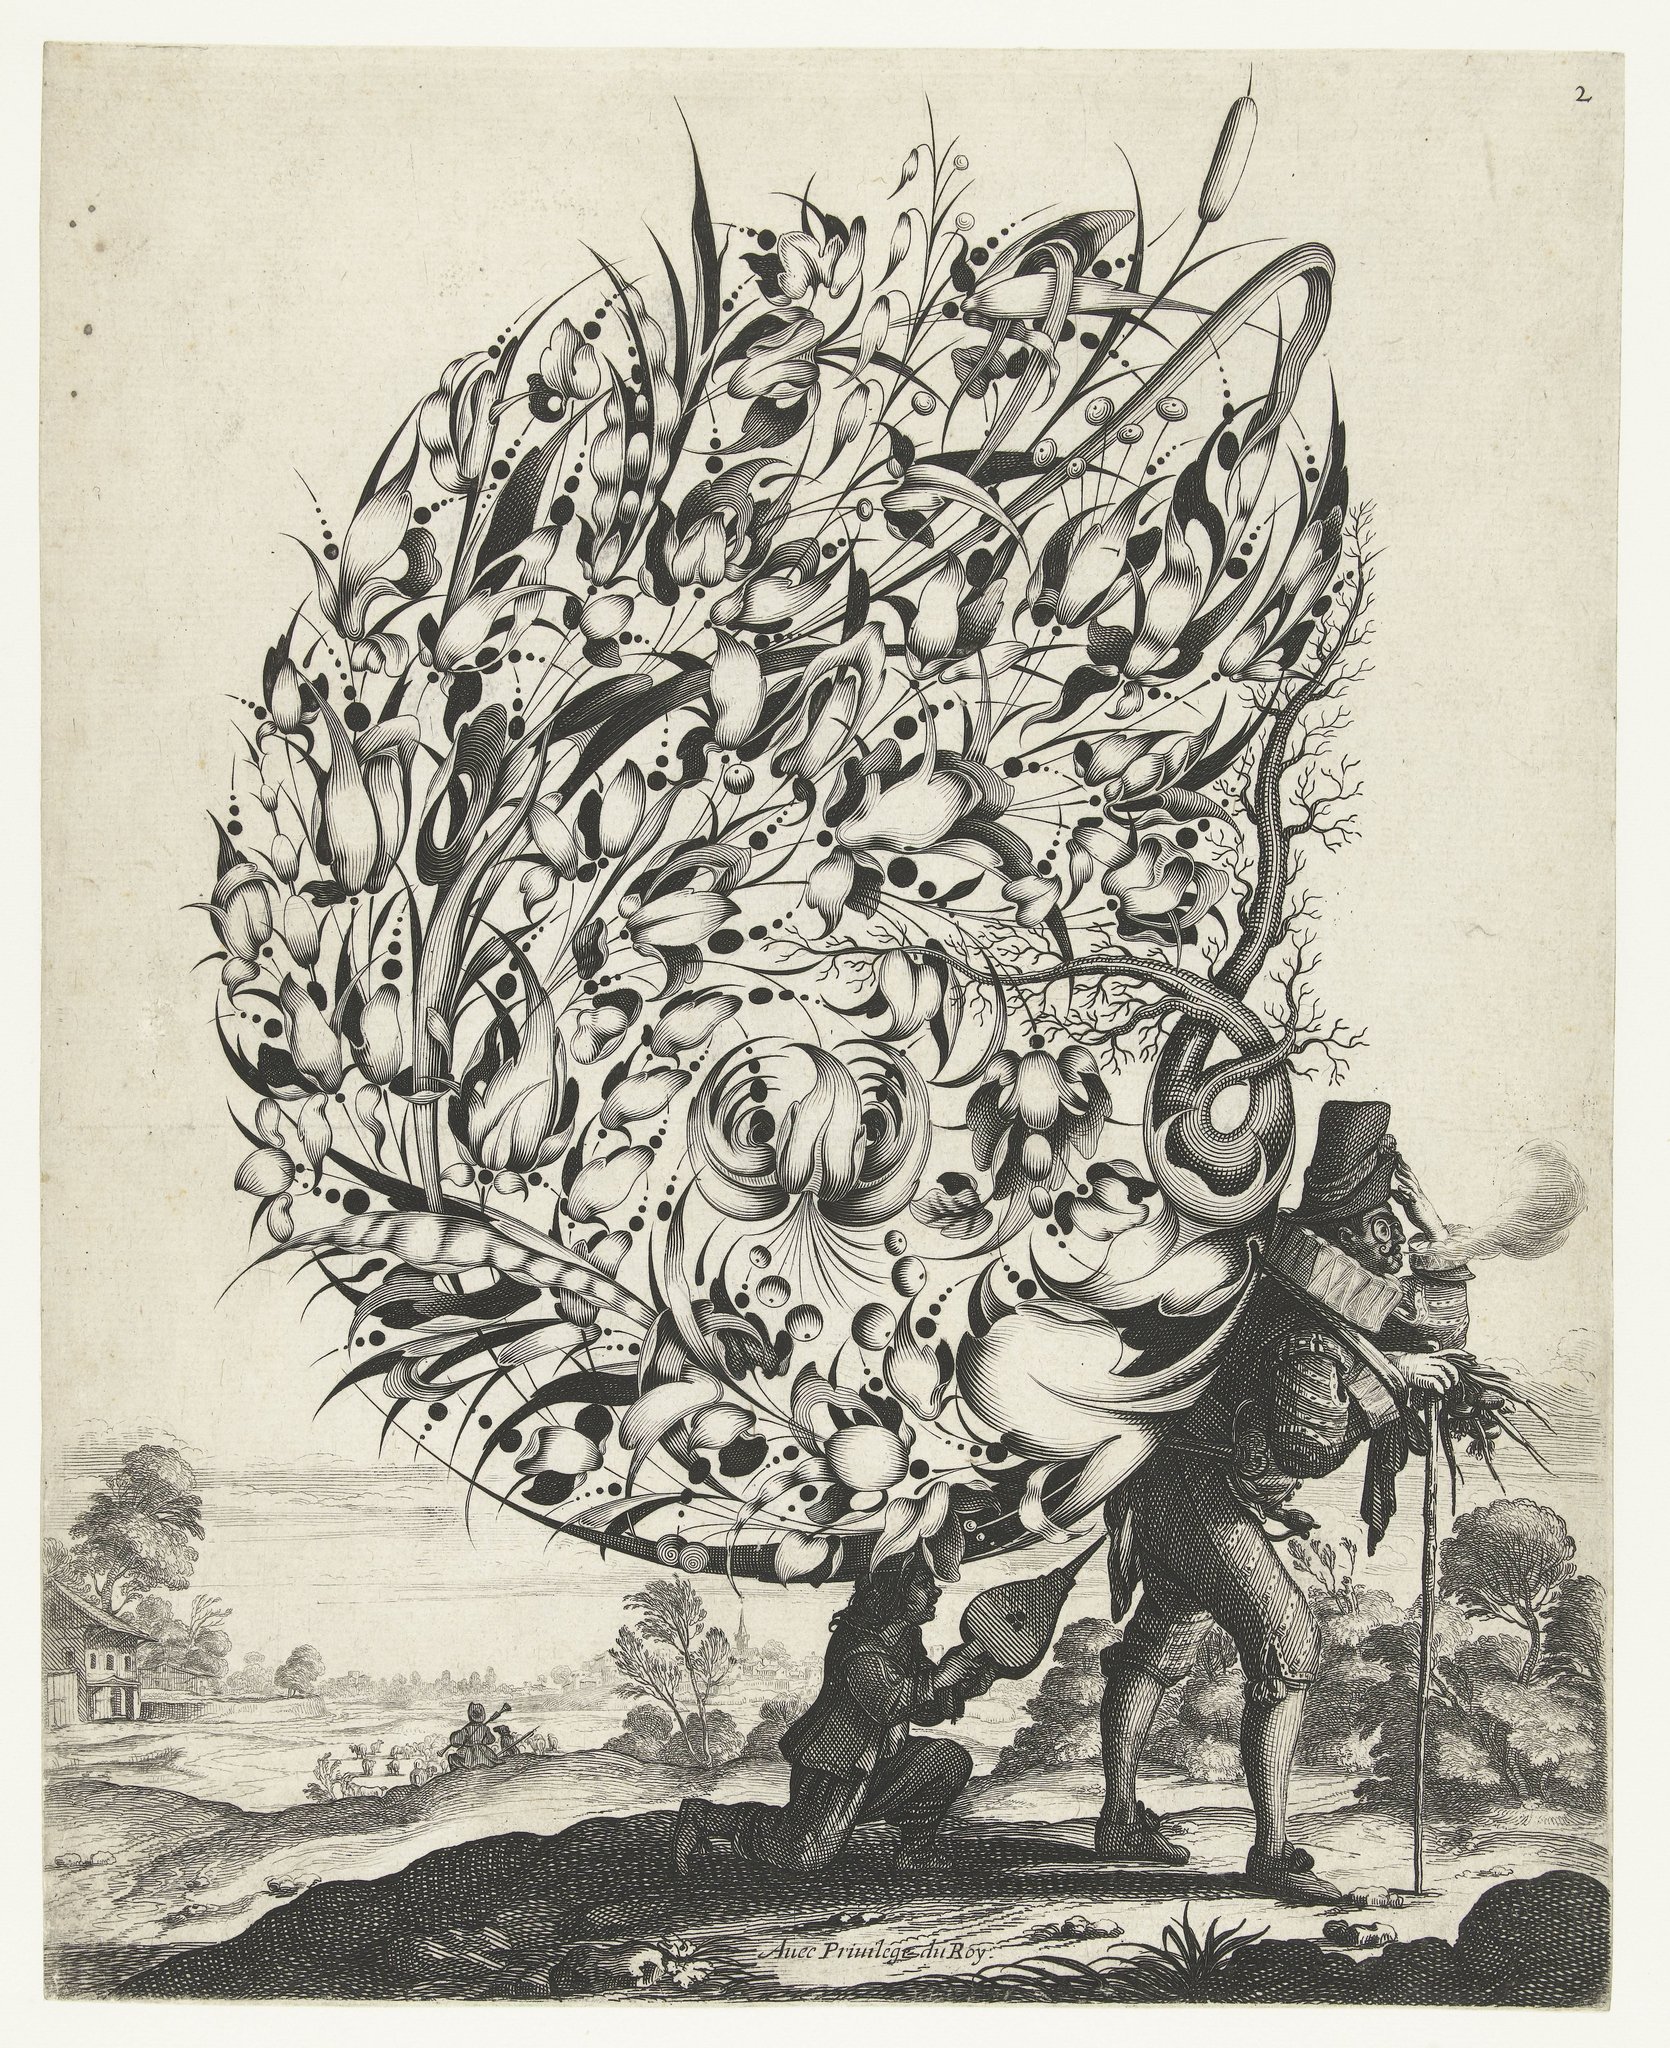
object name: print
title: Livre de Toutes sortes de feüilles Servant a L'orphevrerie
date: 1635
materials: paper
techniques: engraving, etching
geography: france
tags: pedlar, ornament derived from plant forms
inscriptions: date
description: Boeket voor goud- en zilversmeden met bloemen, gestileerde bladeren en peulvruchten. Met een spottende verbeelding van een Spanjaard, bij wie er een nare lucht uit zijn mond en achterste komt.